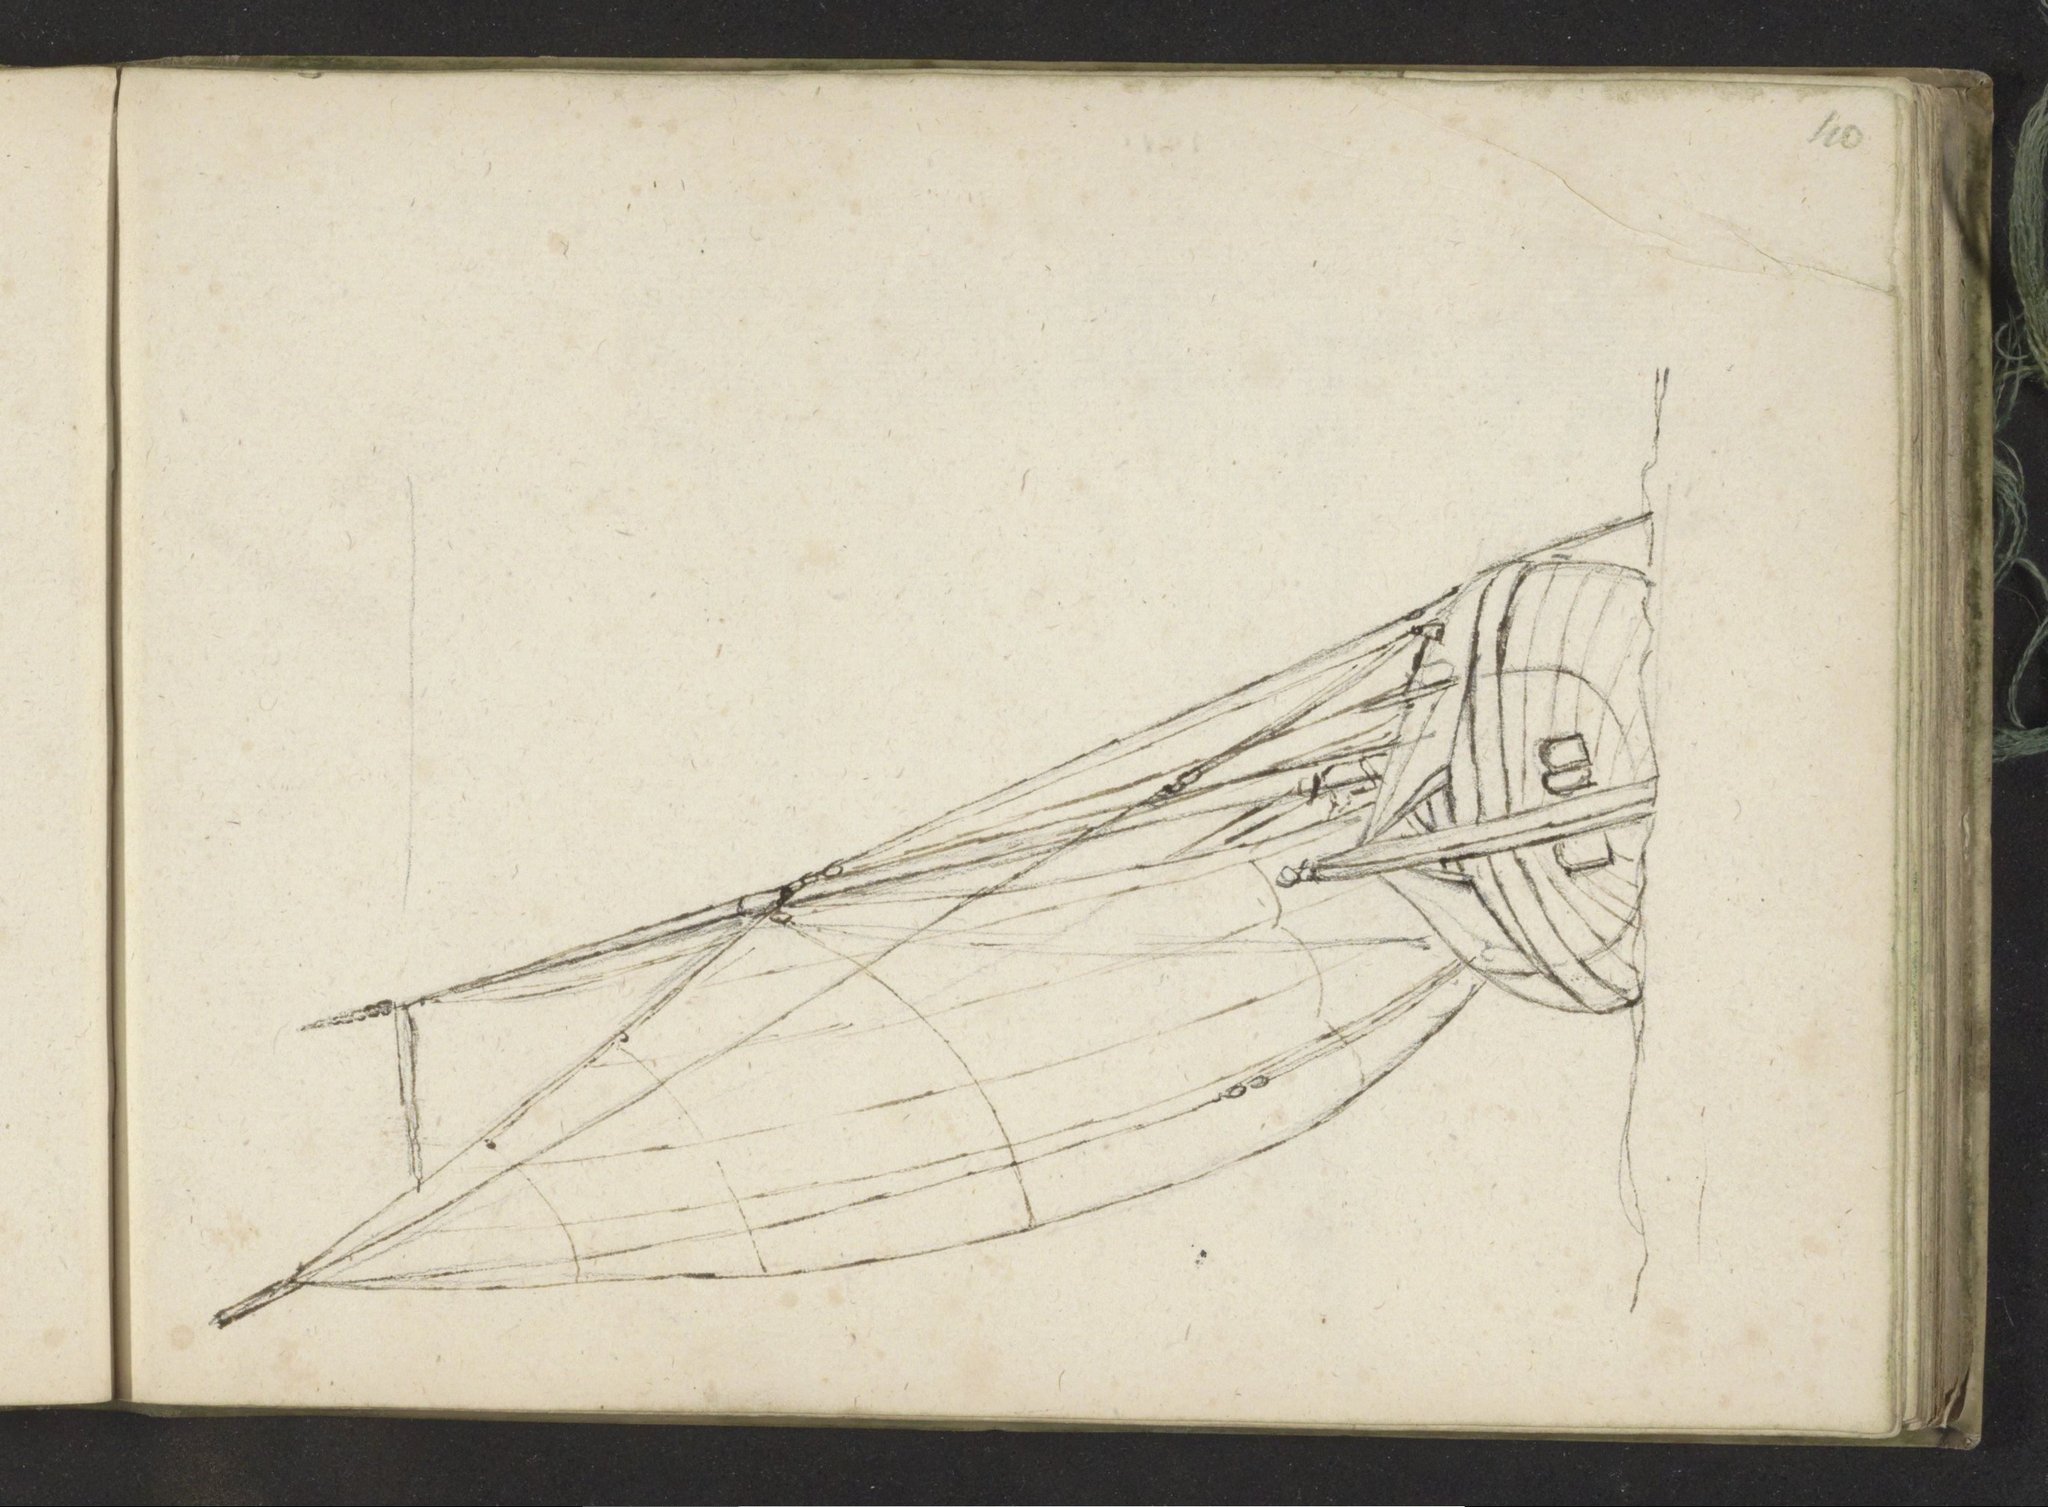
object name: sketchbook leaf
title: Man op een zeilschip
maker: martinus schouman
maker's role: draughtsman, painter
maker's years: 1770-1848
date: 1780-1848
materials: ink, paper, pencil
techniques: pen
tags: crew ~ ship, sailing-ship, sailing-boat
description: Blad 40 recto uit een schetsboek met 53 bladen.